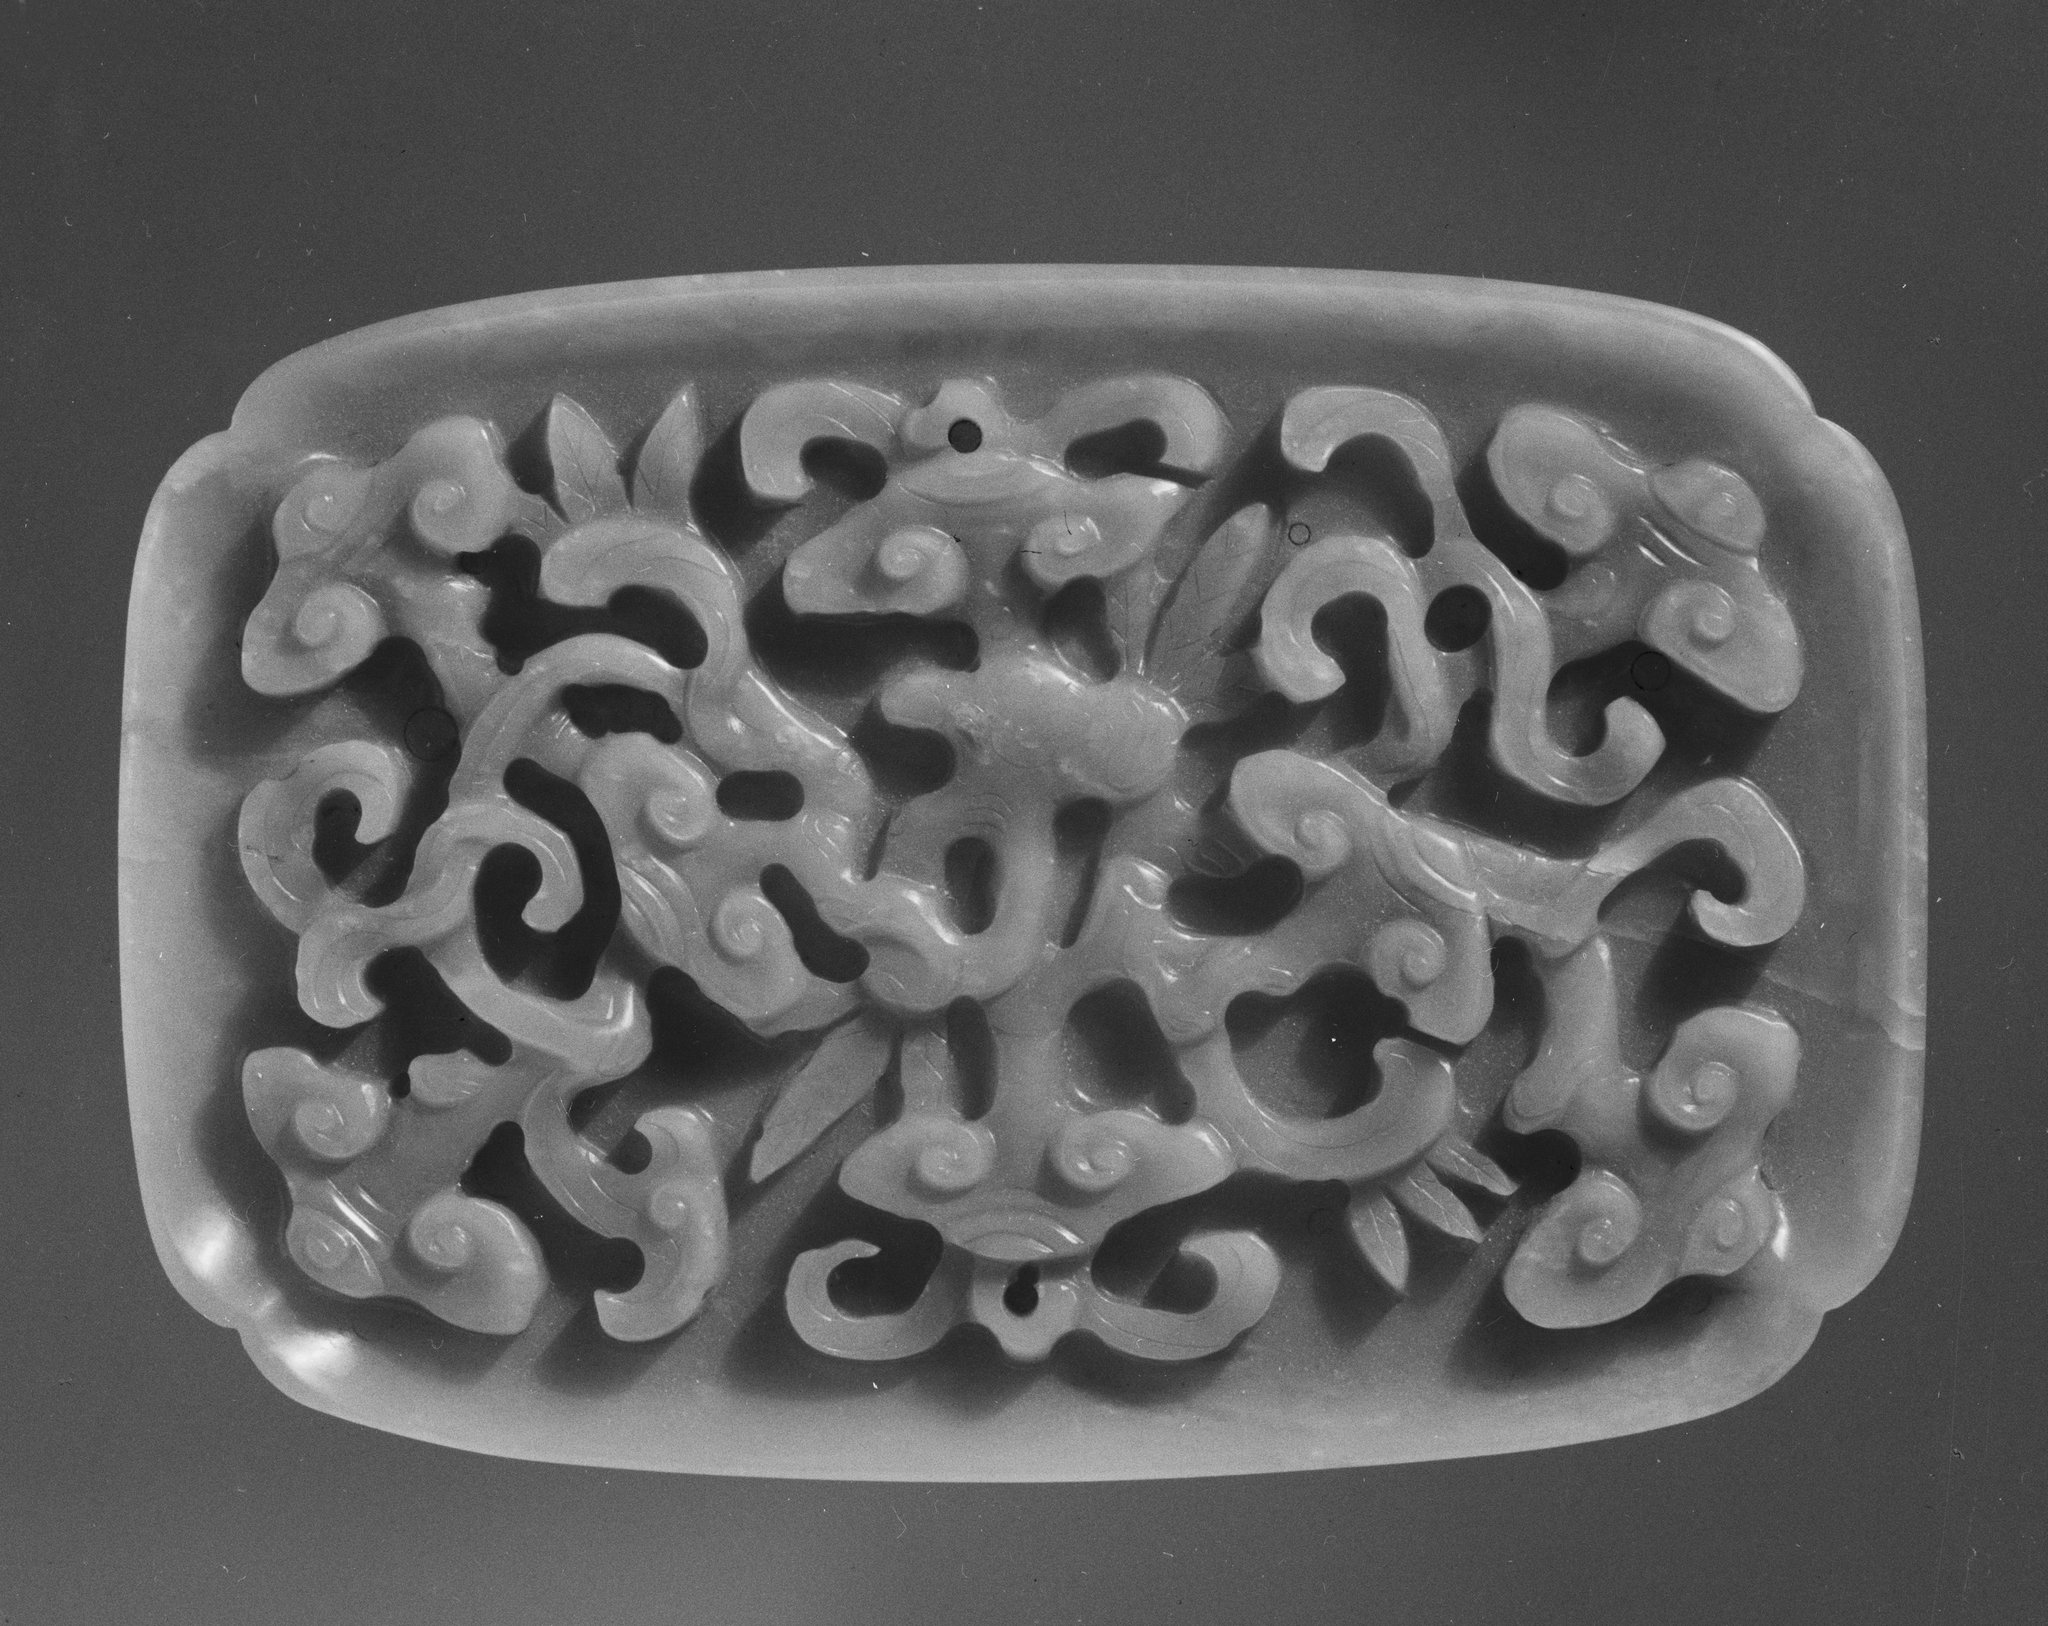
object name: tray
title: Tray with magic fungus (lingzhi)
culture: chinese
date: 1767-1833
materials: jade